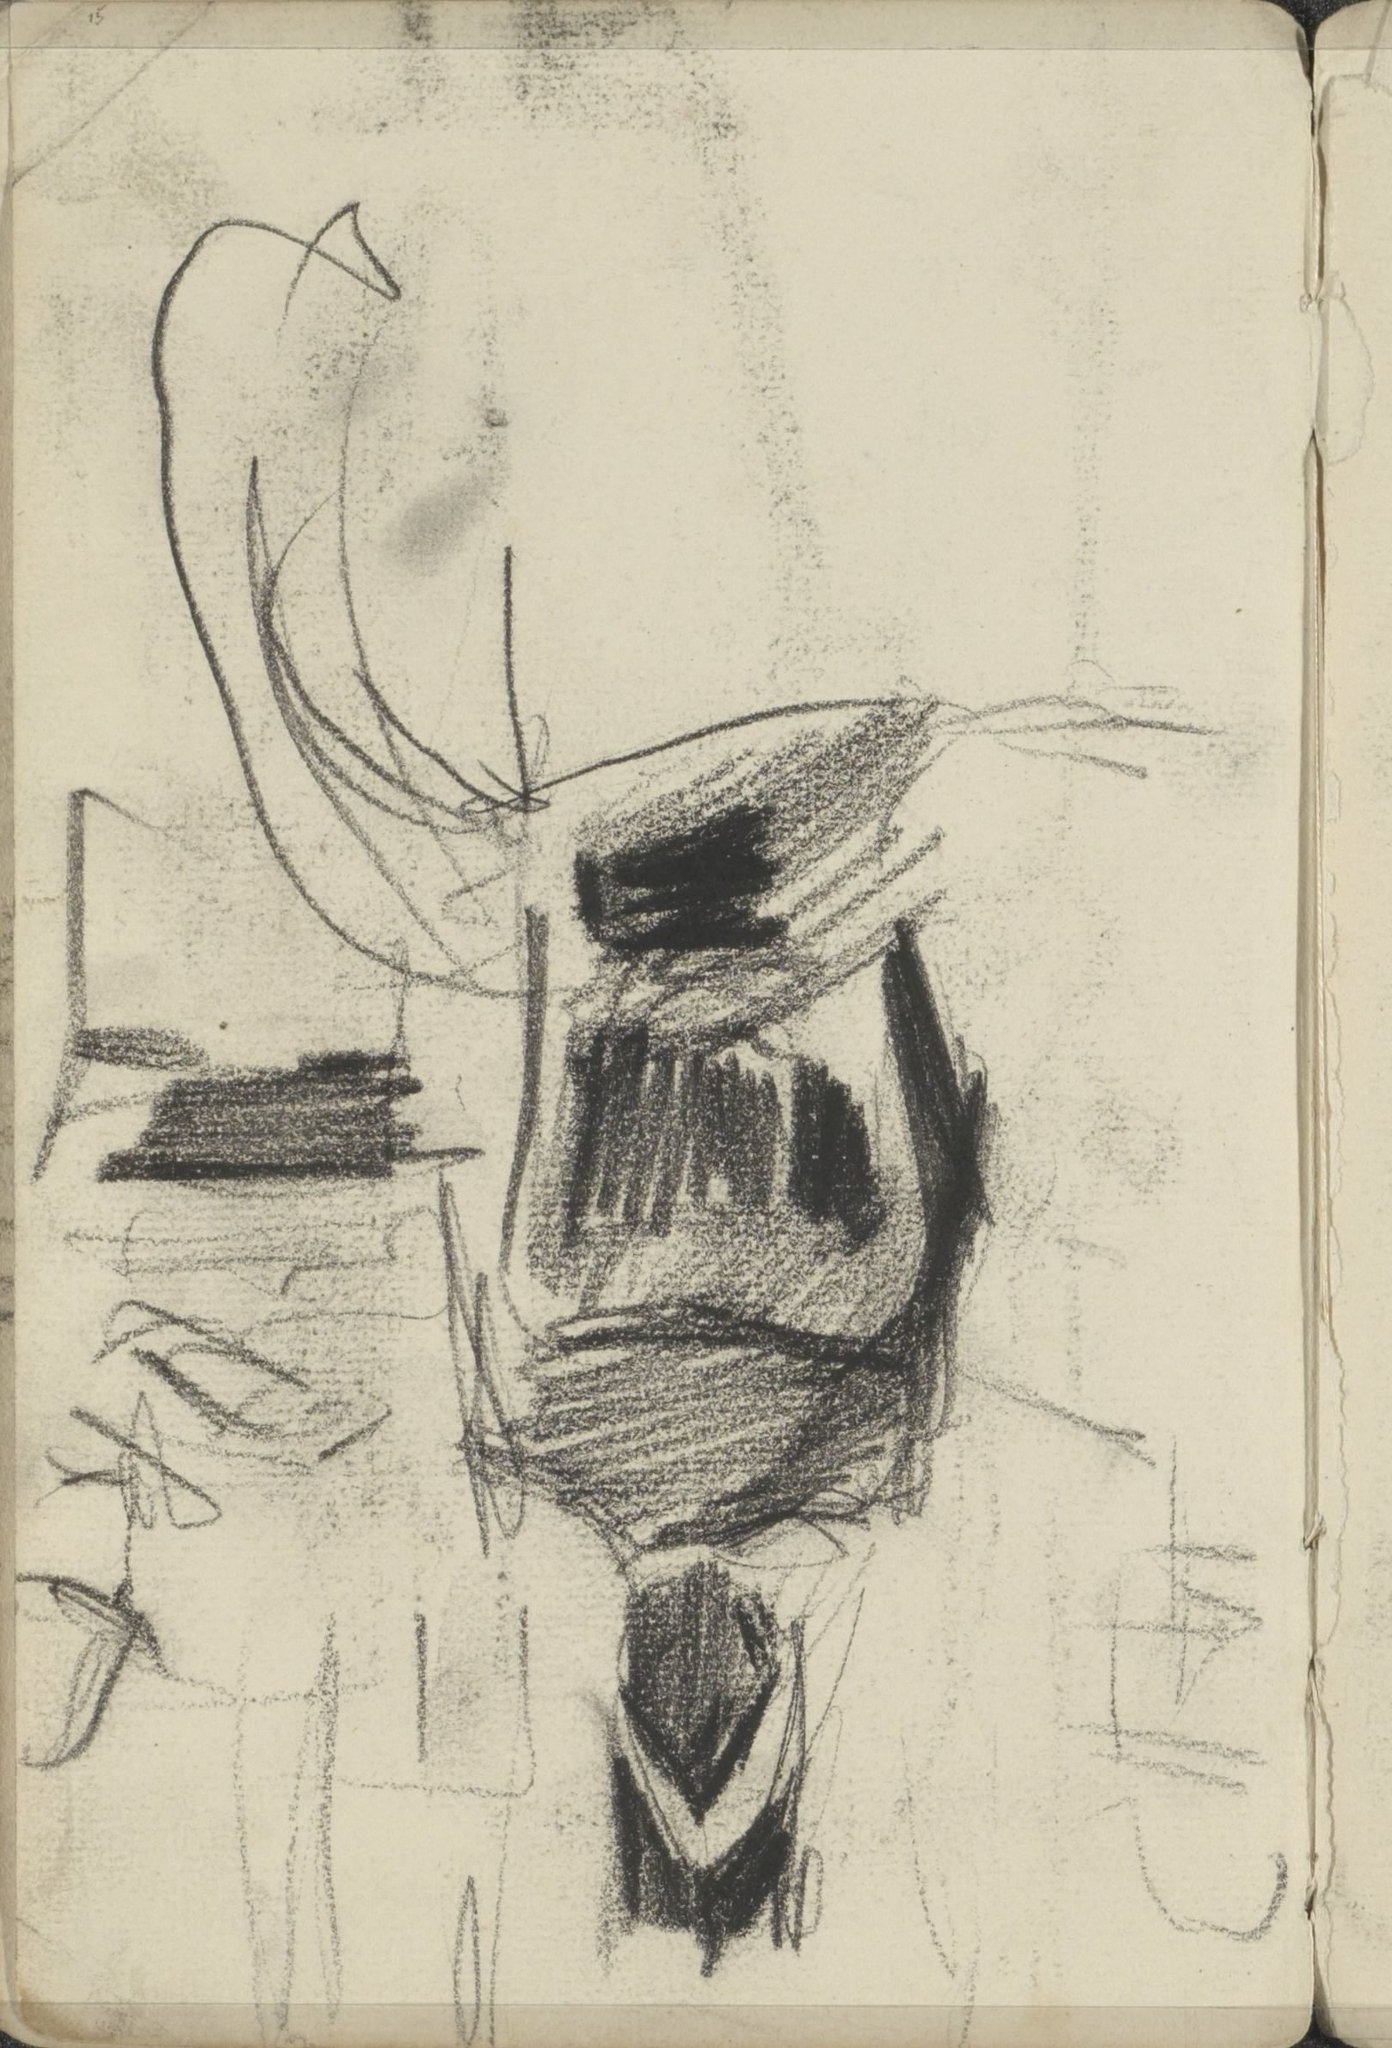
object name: sketchbook leaf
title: Vrouw, op de rug gezien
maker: george hendrik breitner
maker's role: draughtsman, painter, print maker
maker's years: 1857-1923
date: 1867-1923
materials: chalk, paper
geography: amsterdam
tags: adult woman (+ back view), adult man, interior of the house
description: Mogelijk in een interieur met mannen. Pagina 15 uit een schetsboek met 10 bladen.